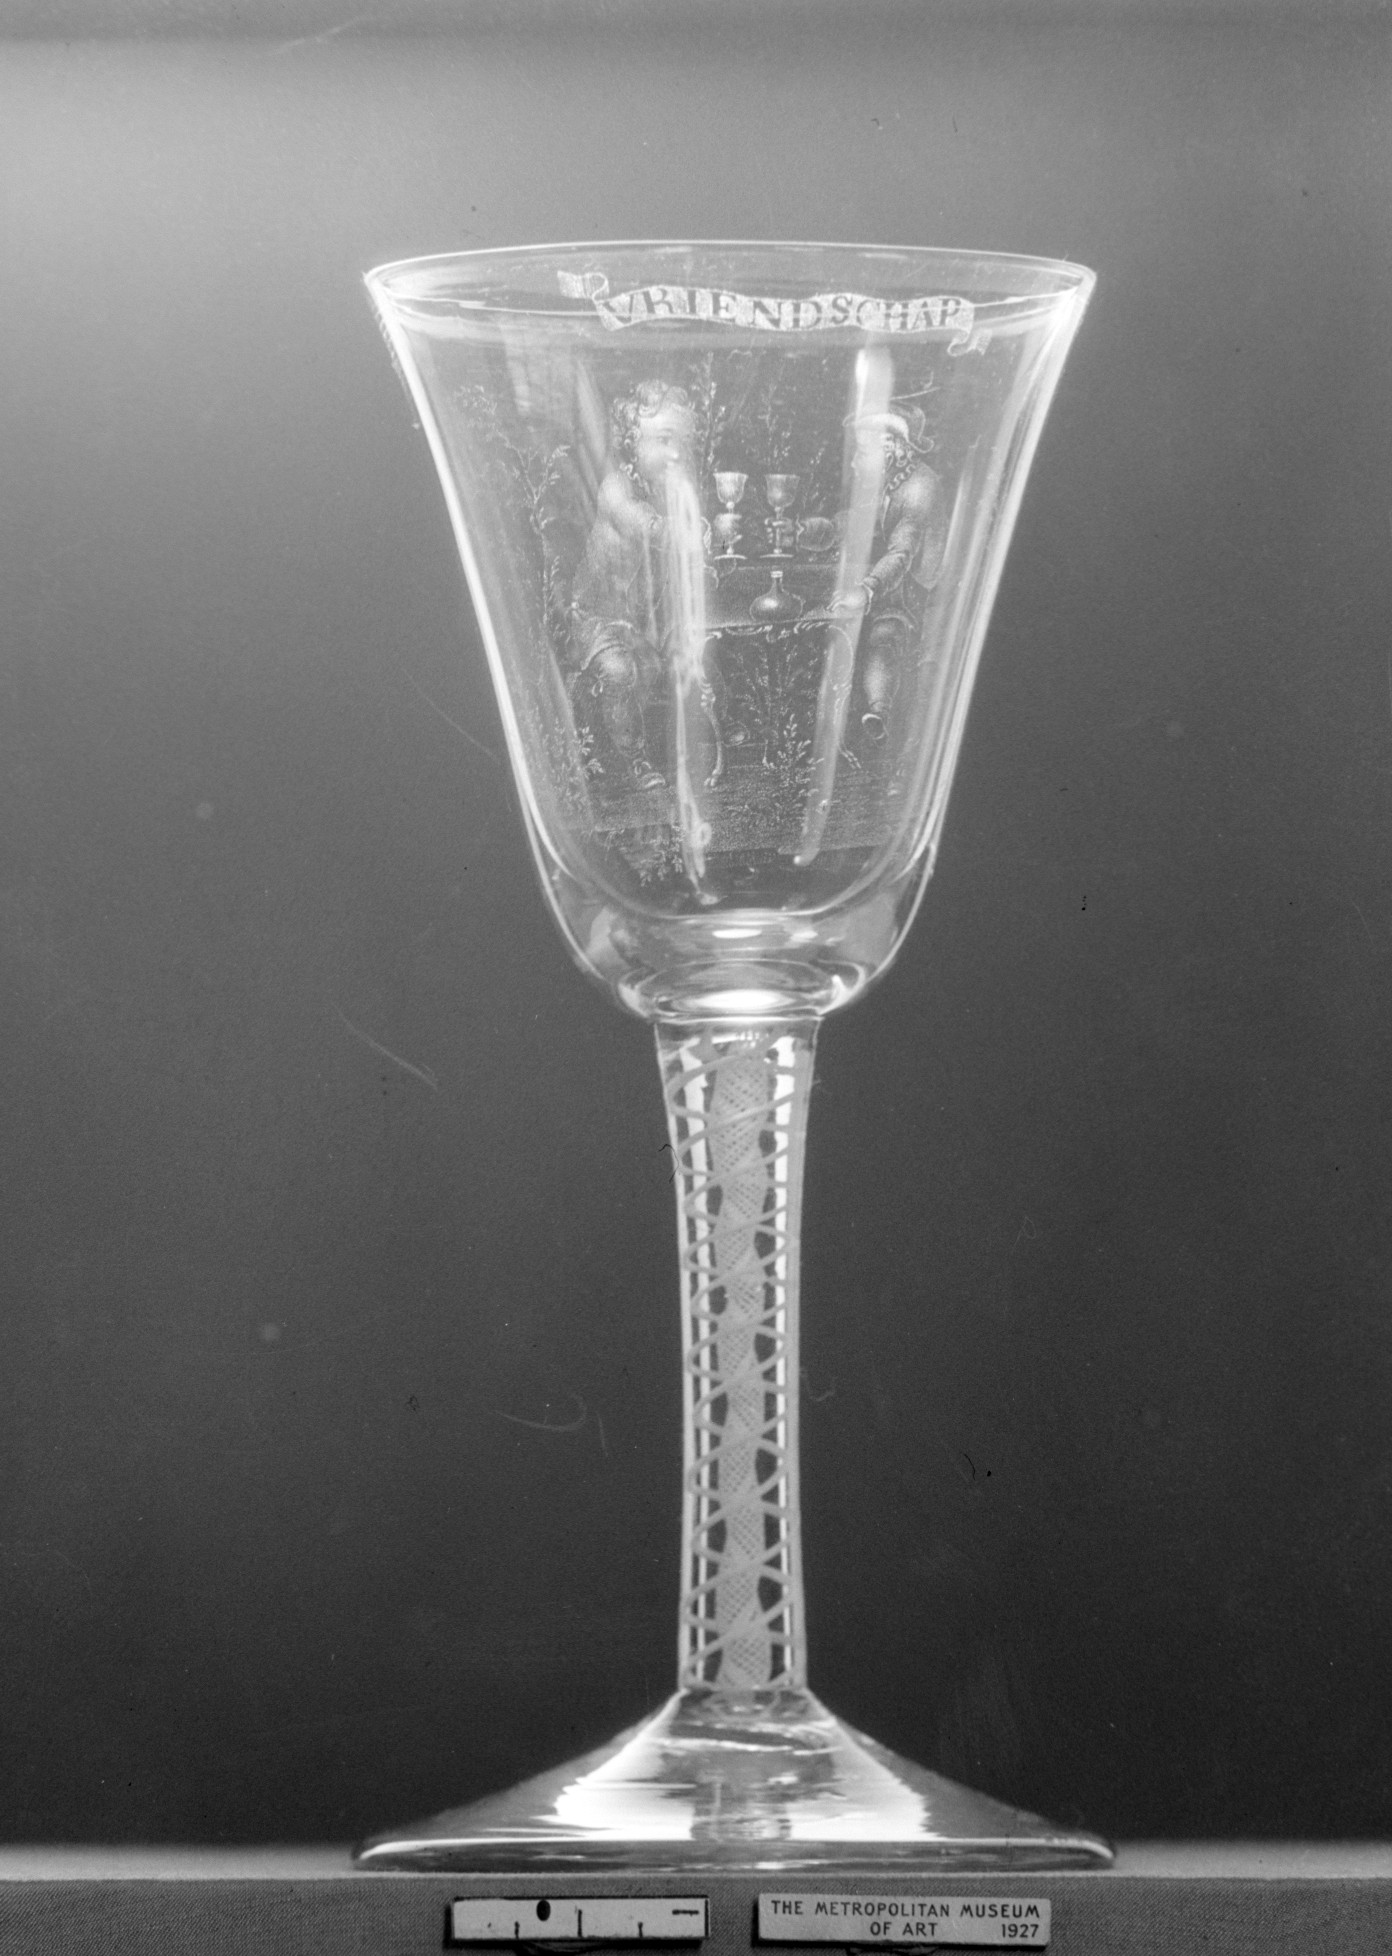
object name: wineglass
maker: david wolff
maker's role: engraver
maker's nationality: dutch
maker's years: 1732-1798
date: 1780-1785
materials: glass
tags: men,women,drinking